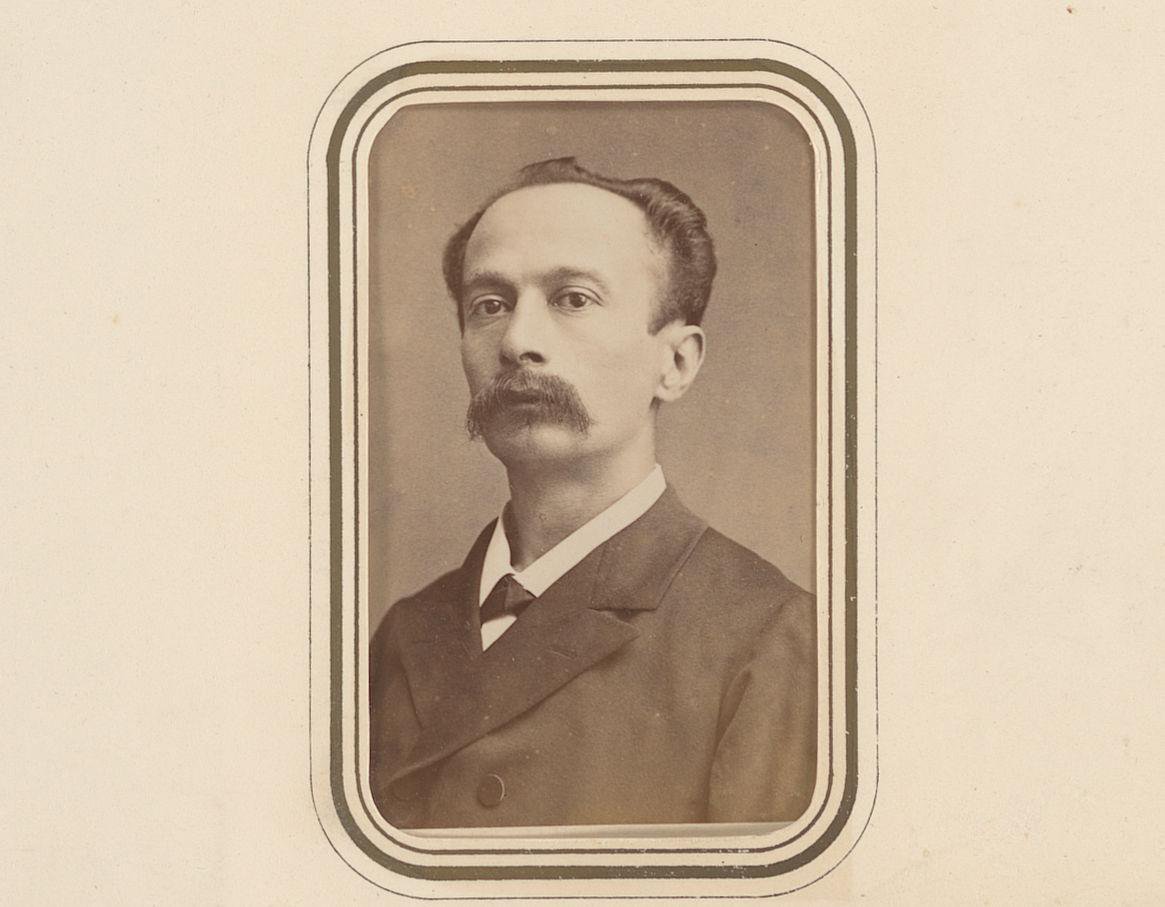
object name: photograph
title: Mansportret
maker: Anonymous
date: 1880-1886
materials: photographic support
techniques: photography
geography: dutch east indies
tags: the hague, anonymous historical person portrayed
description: Carte-de-visite met het portret van een onbekende man. Waarschijnlijk één van de aanbieders van het fotoalbum. Ingestoken in het fotoalbum aangeboden aan J.M. Pijnacker Hordijk bij zijn vertrek uit Jogyakarta in 1886.